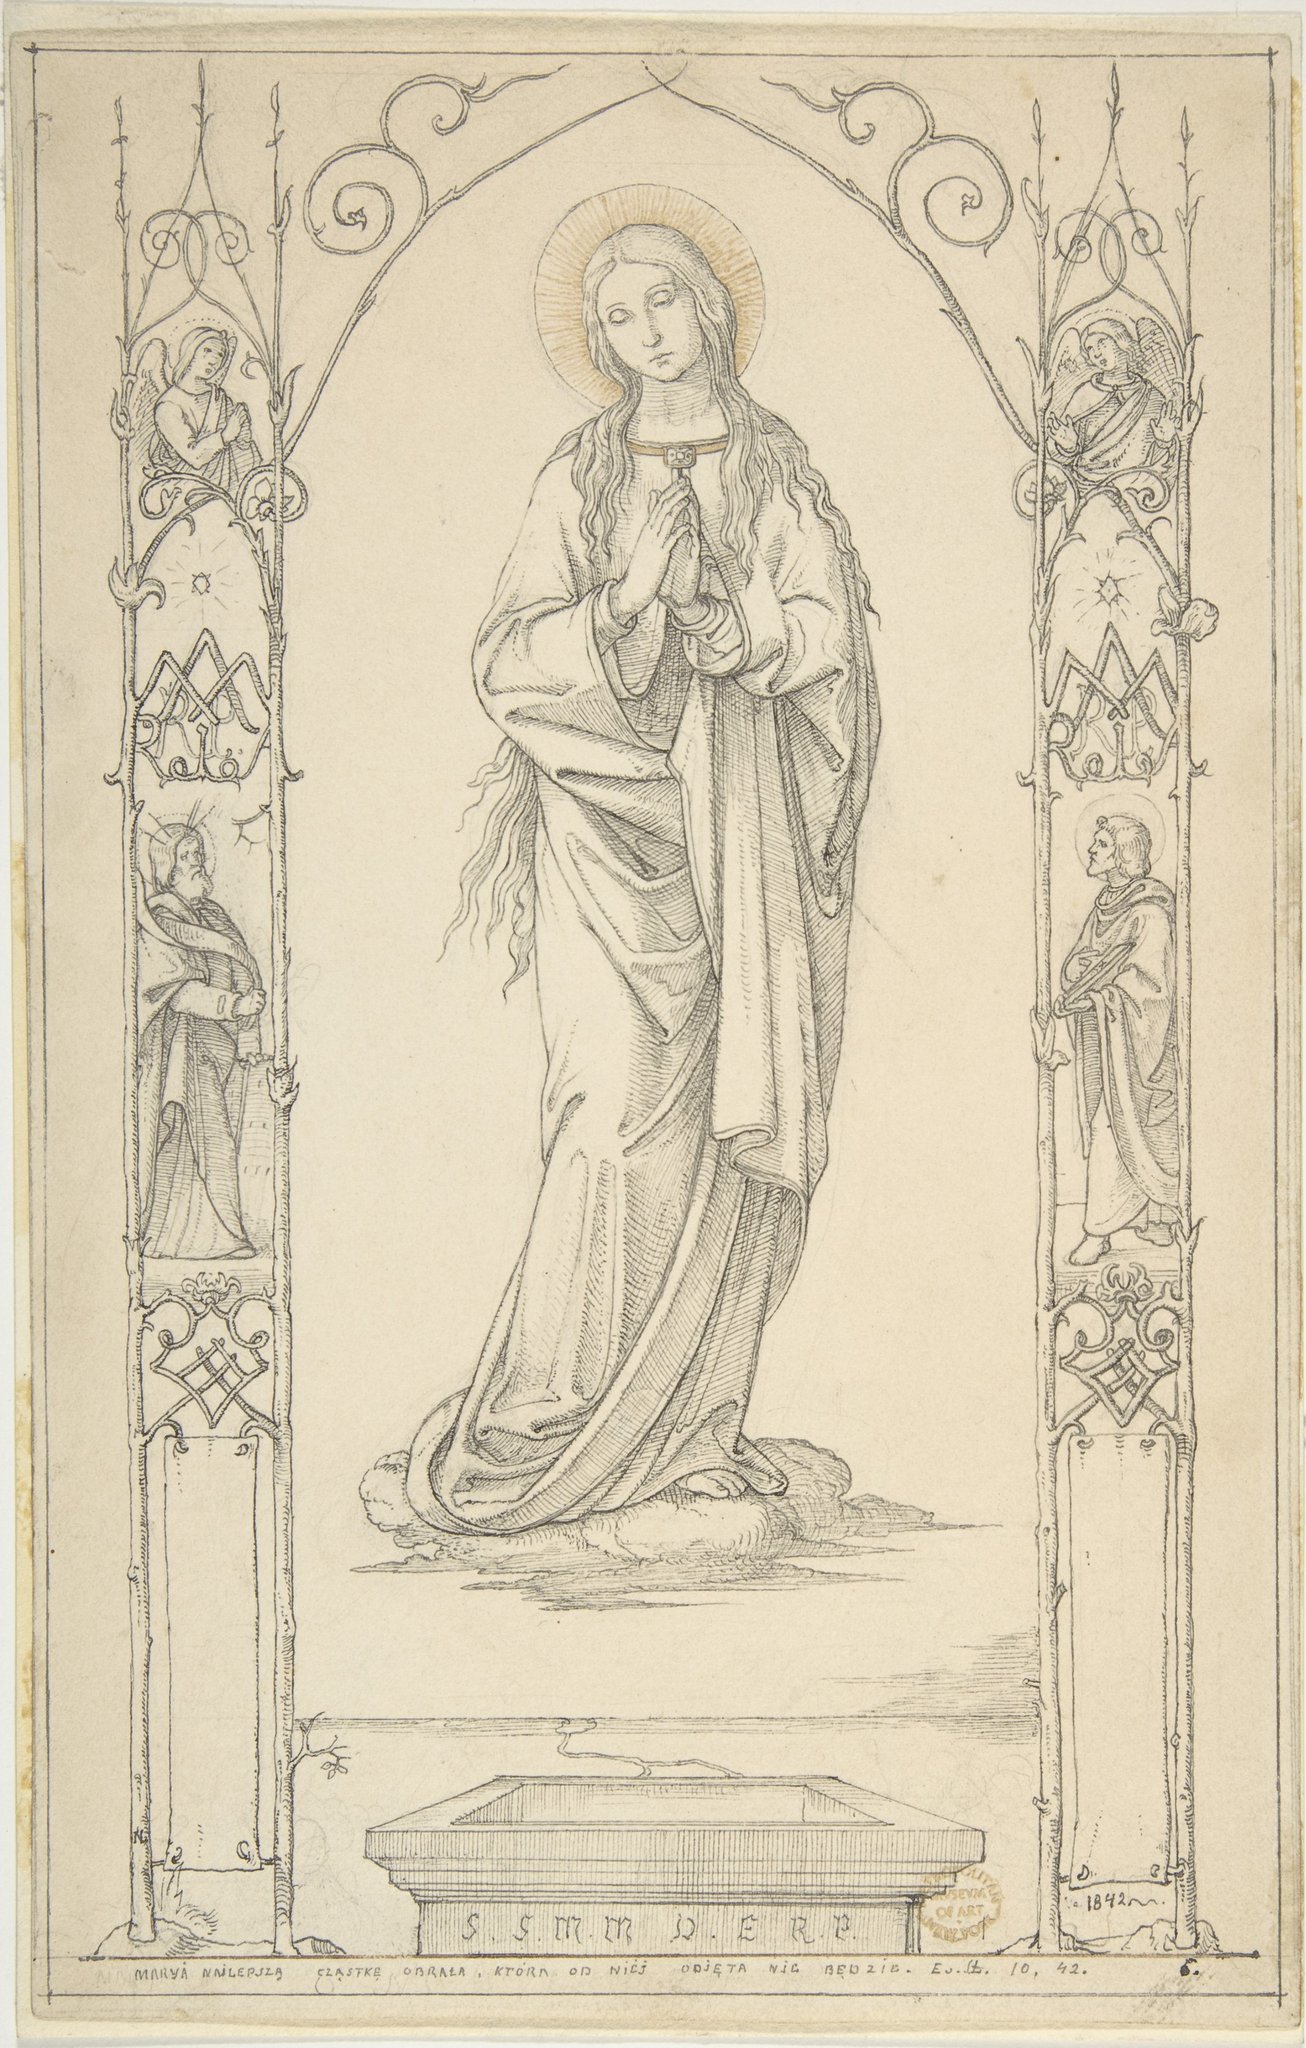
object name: drawing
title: Assumption of the Virgin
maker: monogrammist nl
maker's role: artist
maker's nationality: polish or german?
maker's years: 1800-1900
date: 1842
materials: gold, graphite, ink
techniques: pen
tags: angels,assumption of the virgin,saints